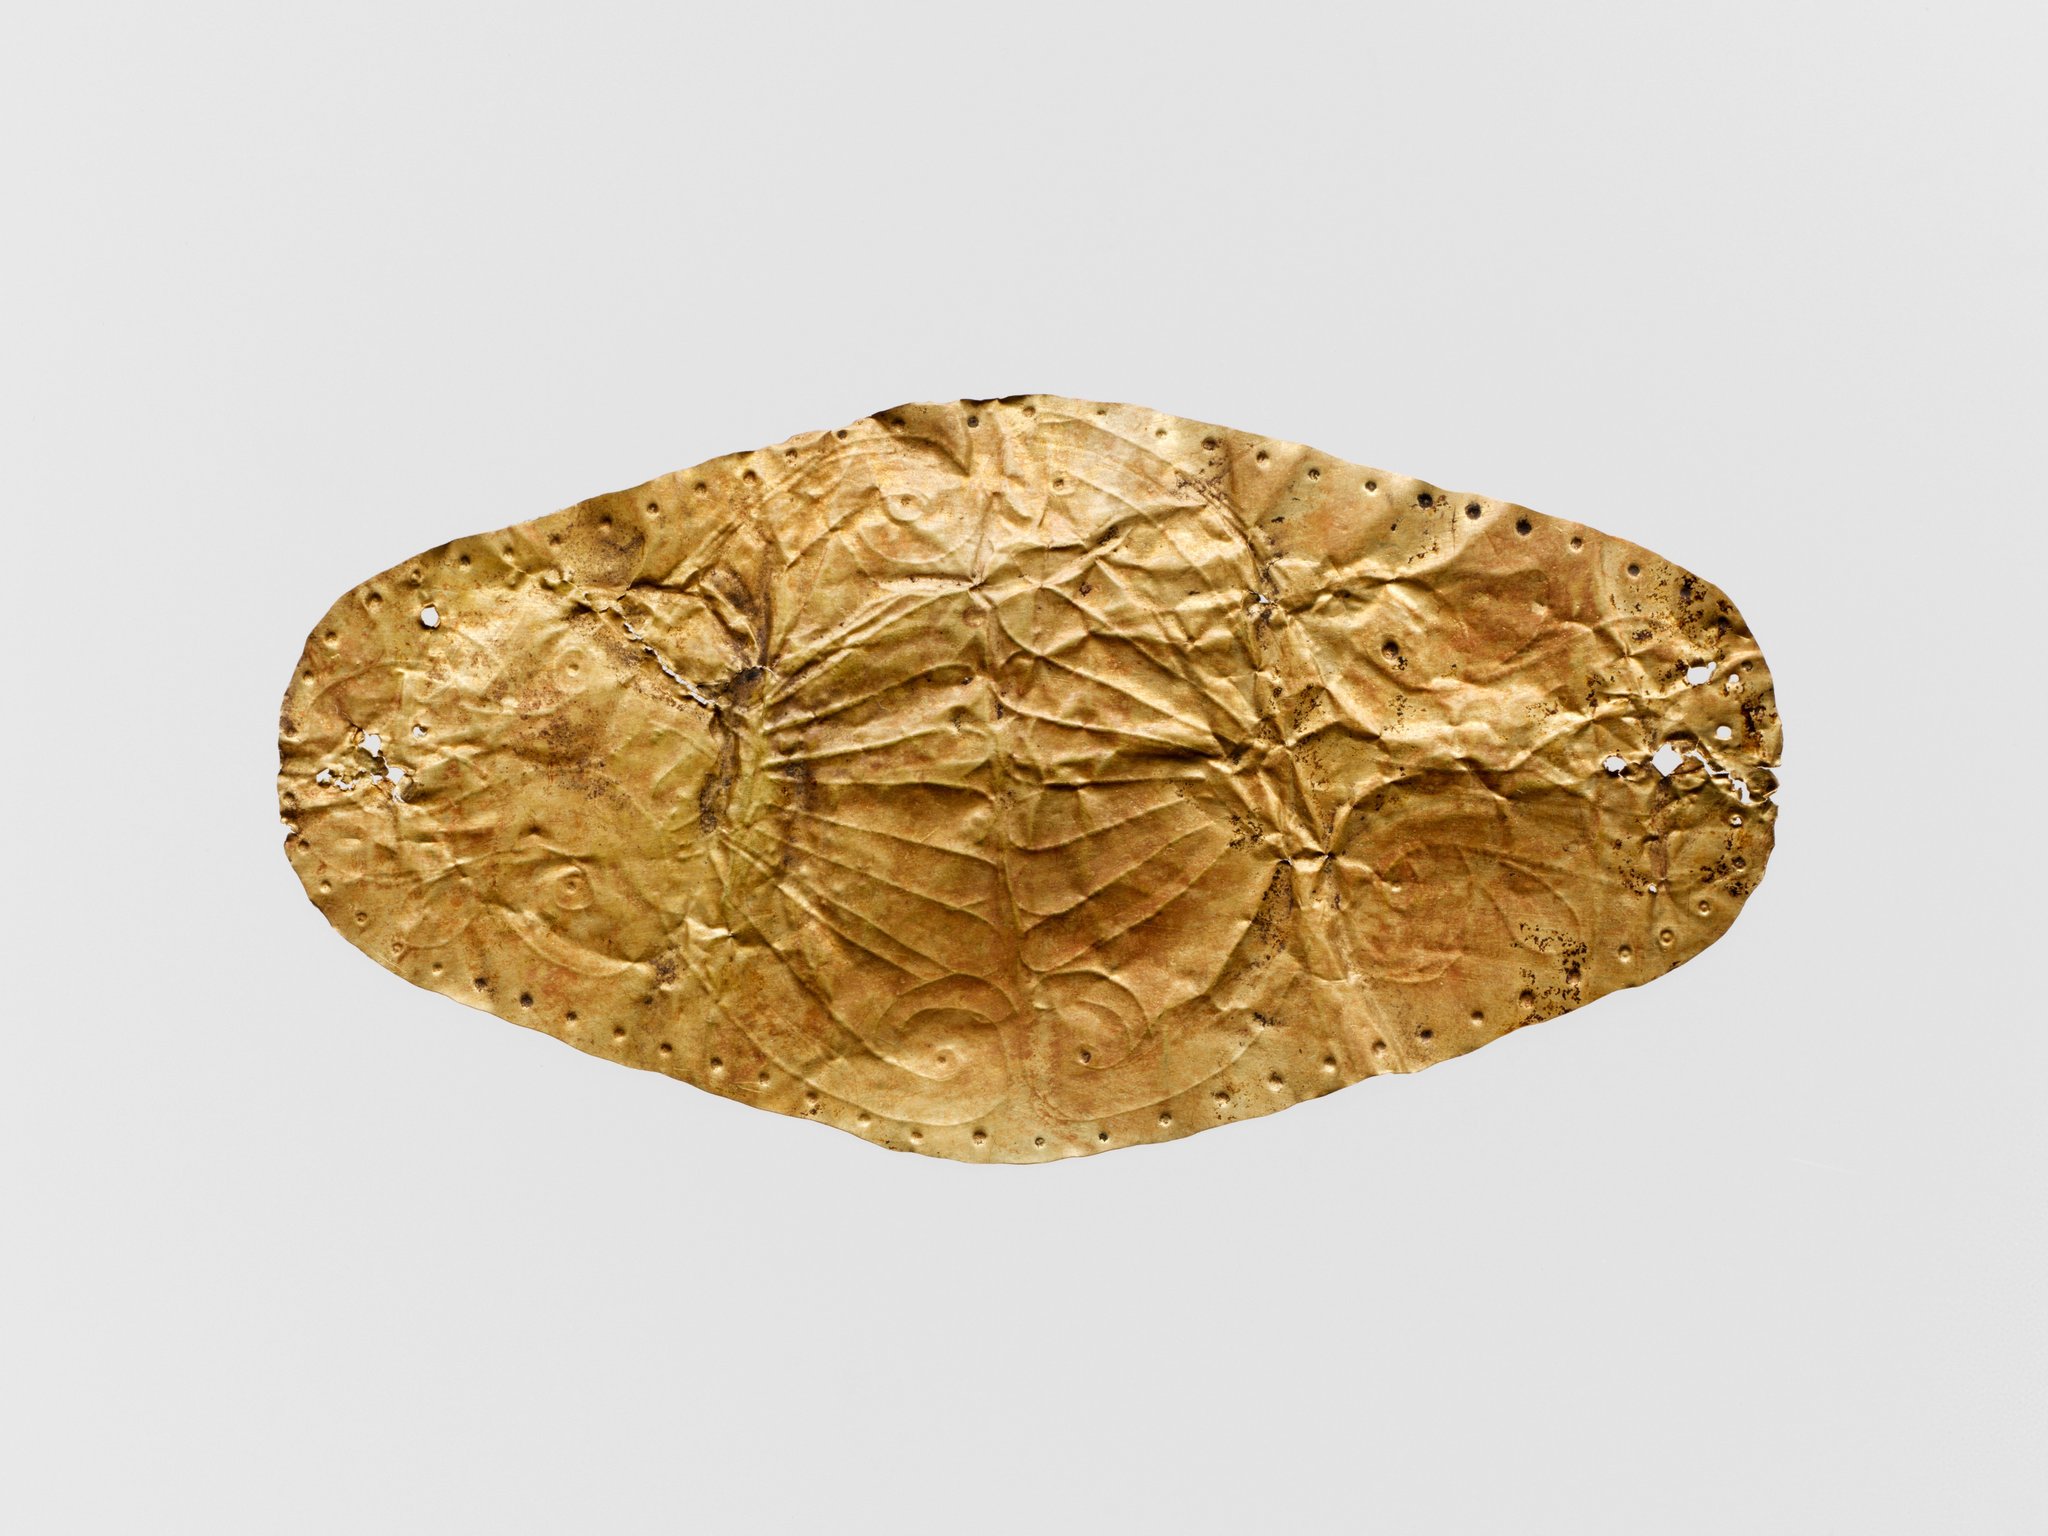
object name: mouth plate or frontlet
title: Gold leaf frontlet (band for forehead)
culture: cypriot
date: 700-501 BCE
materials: gold